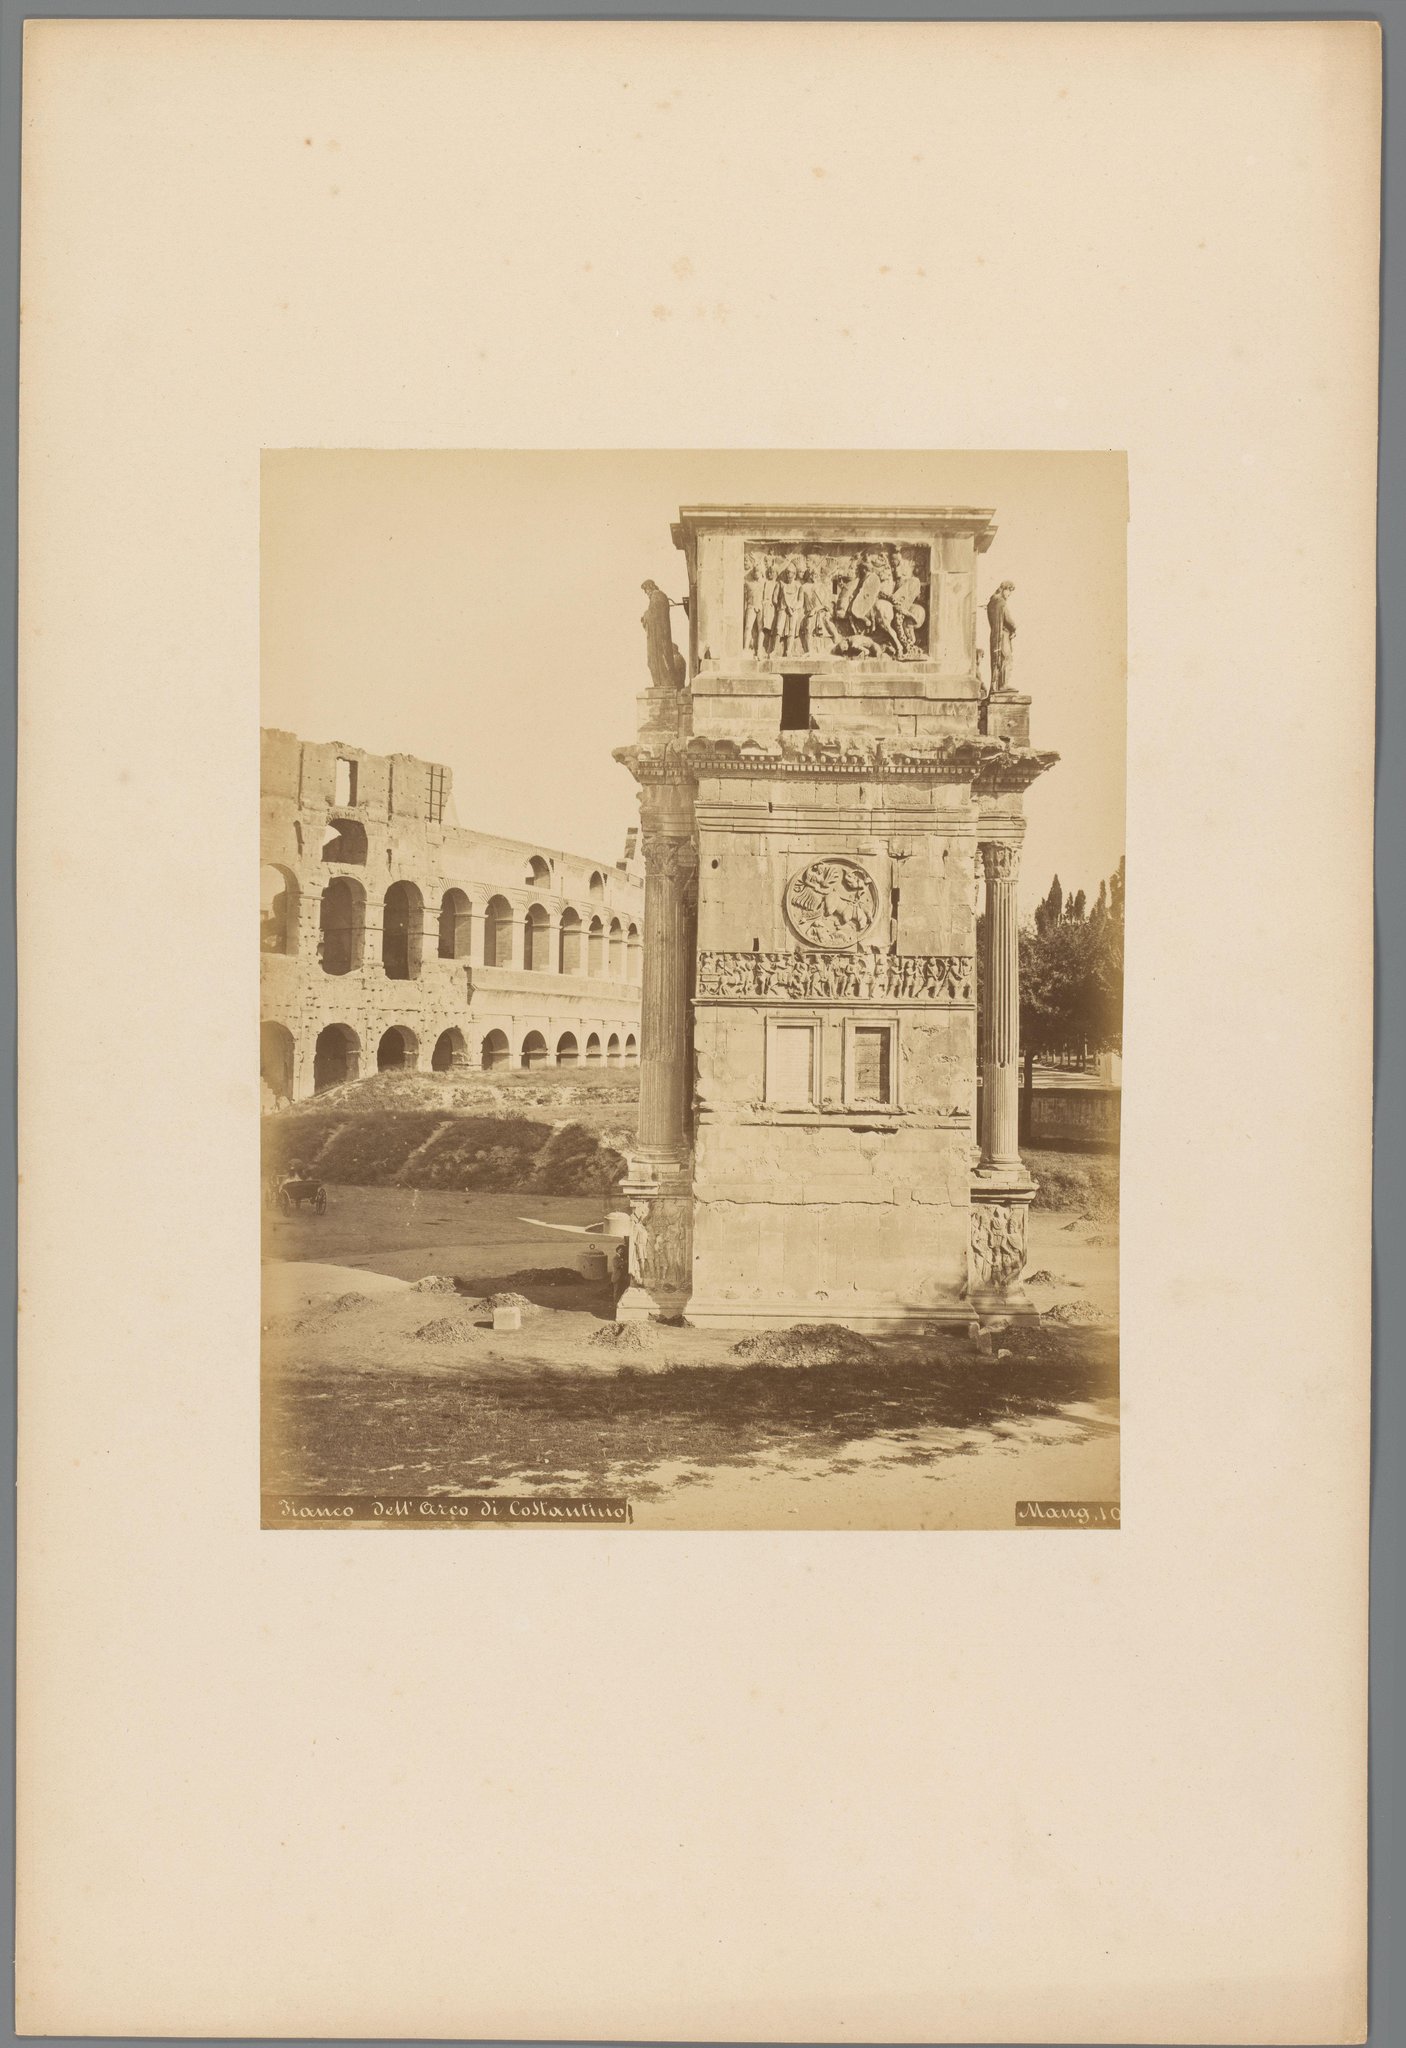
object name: photograph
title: Boog van Constantijn met op de achtergrond het Colosseum te Rome, Italië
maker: michèle mang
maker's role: fotograaf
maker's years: 1840-1909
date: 1863-1887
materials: cardboard, paper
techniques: albumen print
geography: rome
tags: triumphal arch, arch of constantine